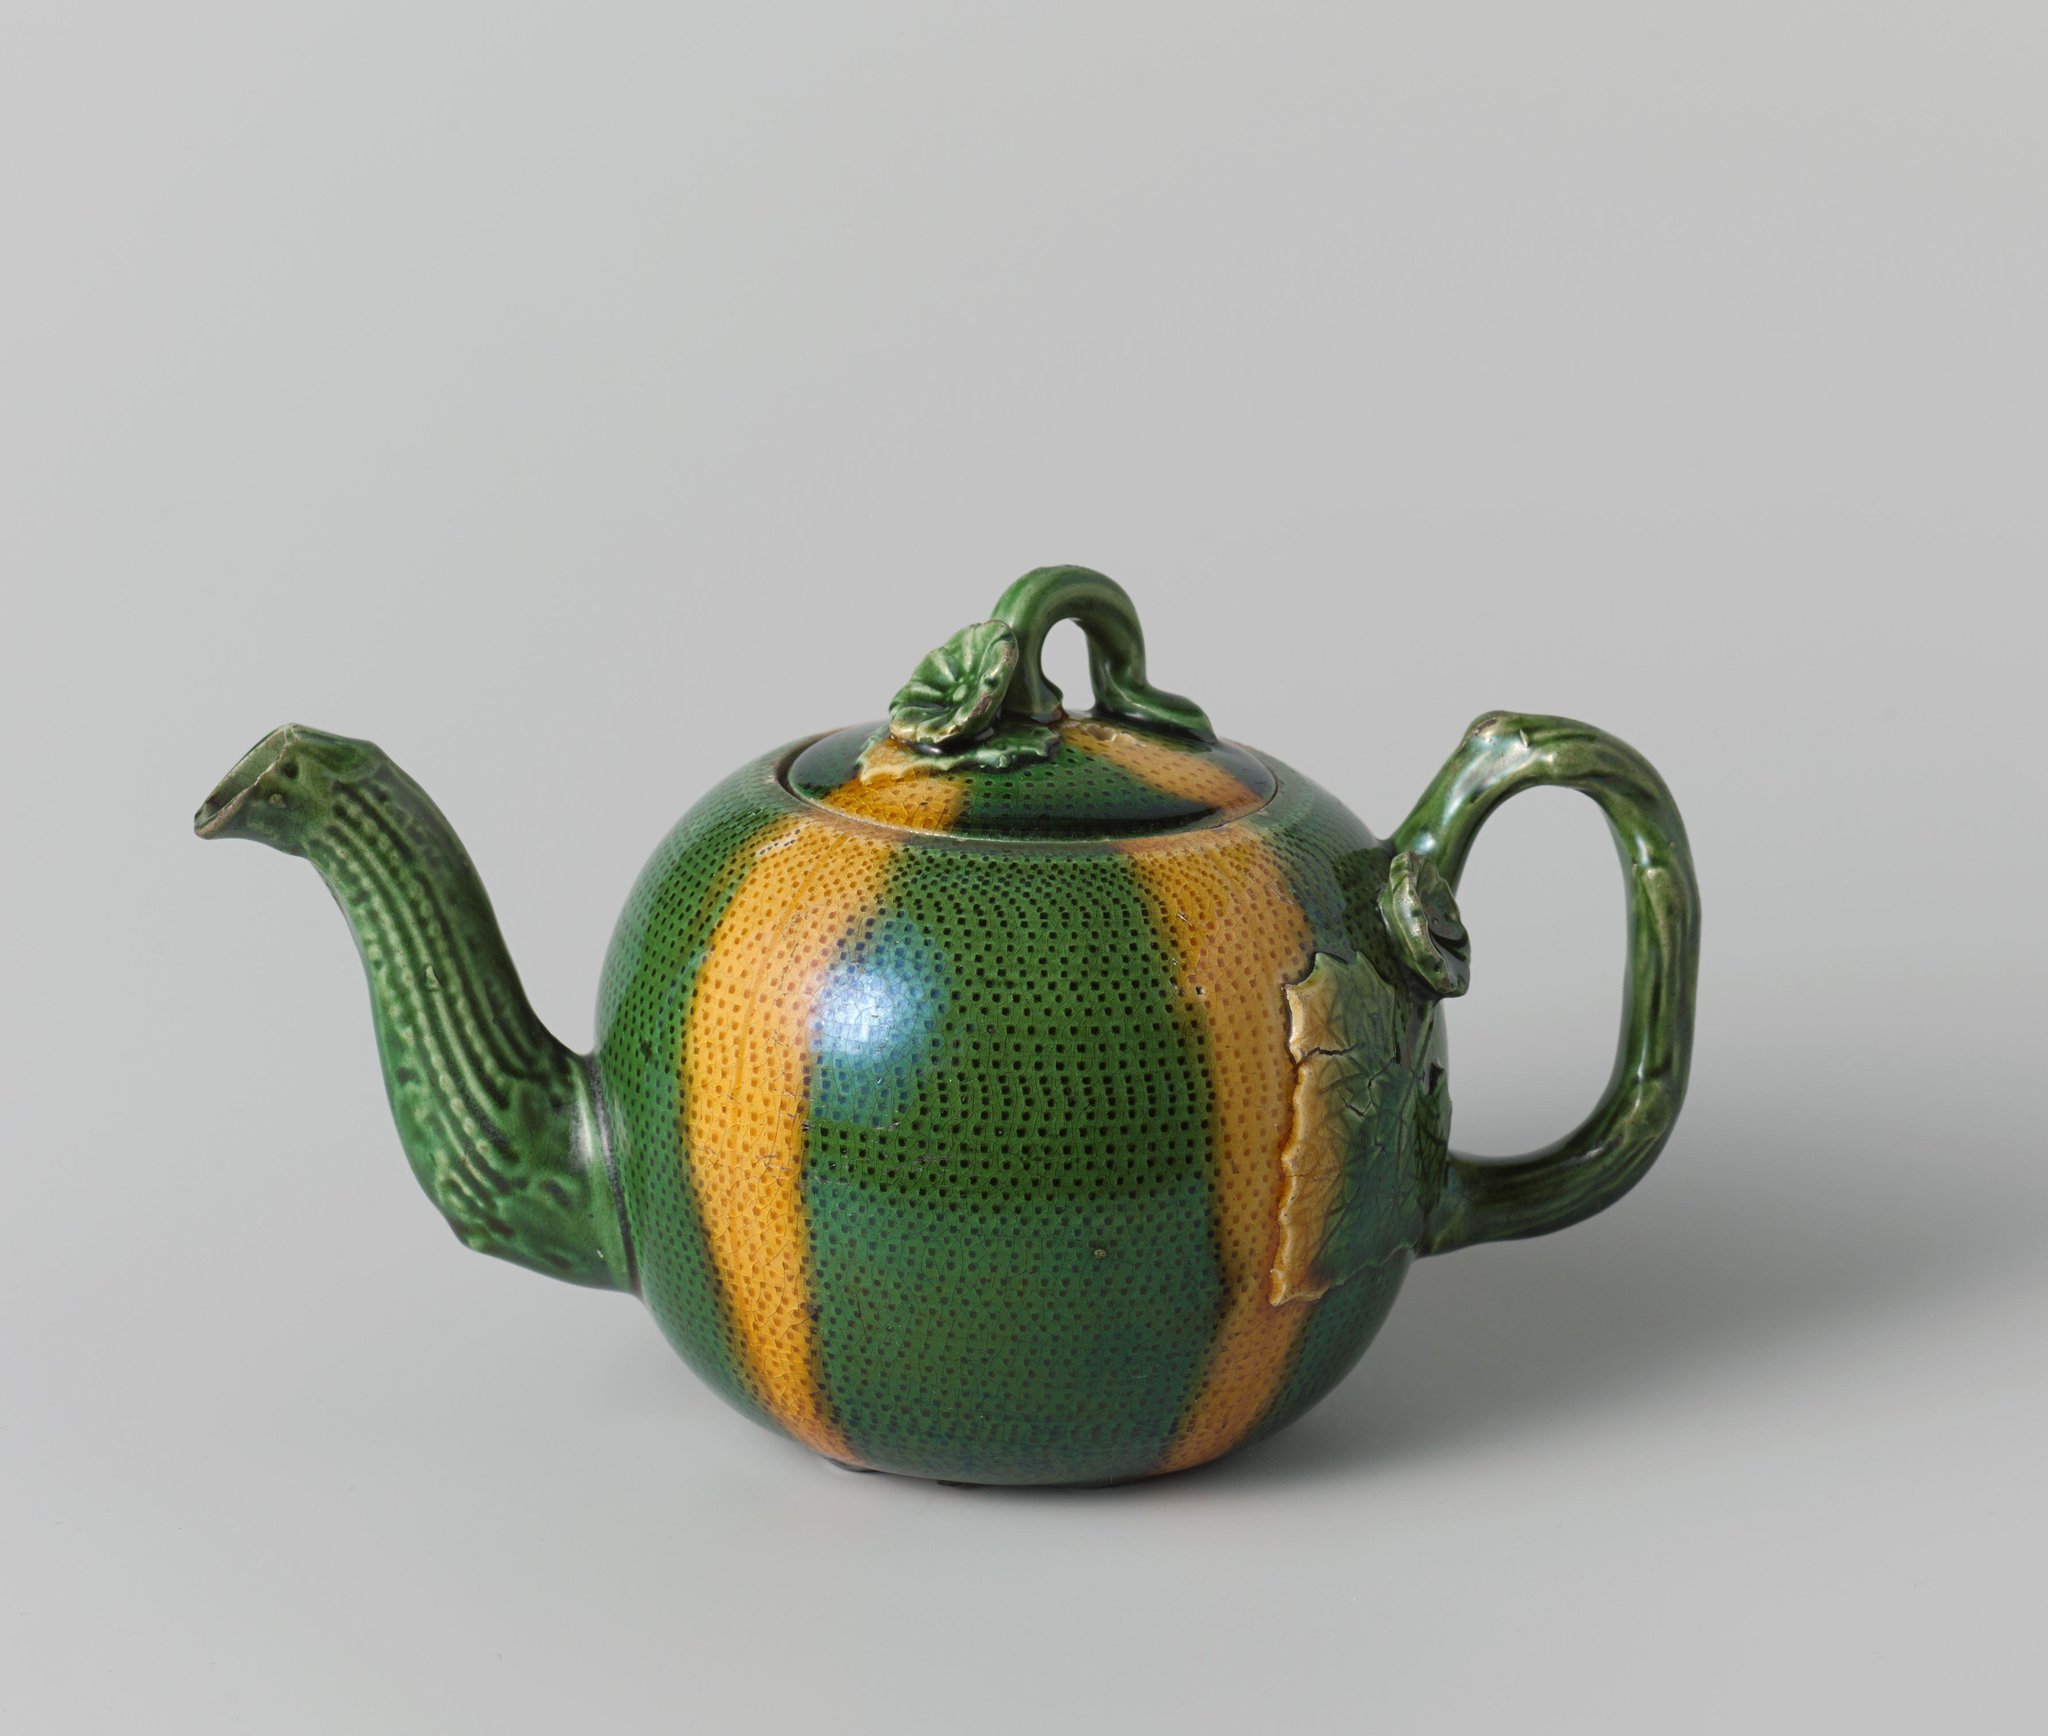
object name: teapot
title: Theepot van hardgebakken aardewerk.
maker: Anonymous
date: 1760-1765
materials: earthenware, glaze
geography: burslem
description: Theepot van hardgebakken aardewerk, bedekt met loodglazuur in groen en geel. De wand bij het oor een rozet met een blad in reliëf. Het oor heeft de vorm van een tak.